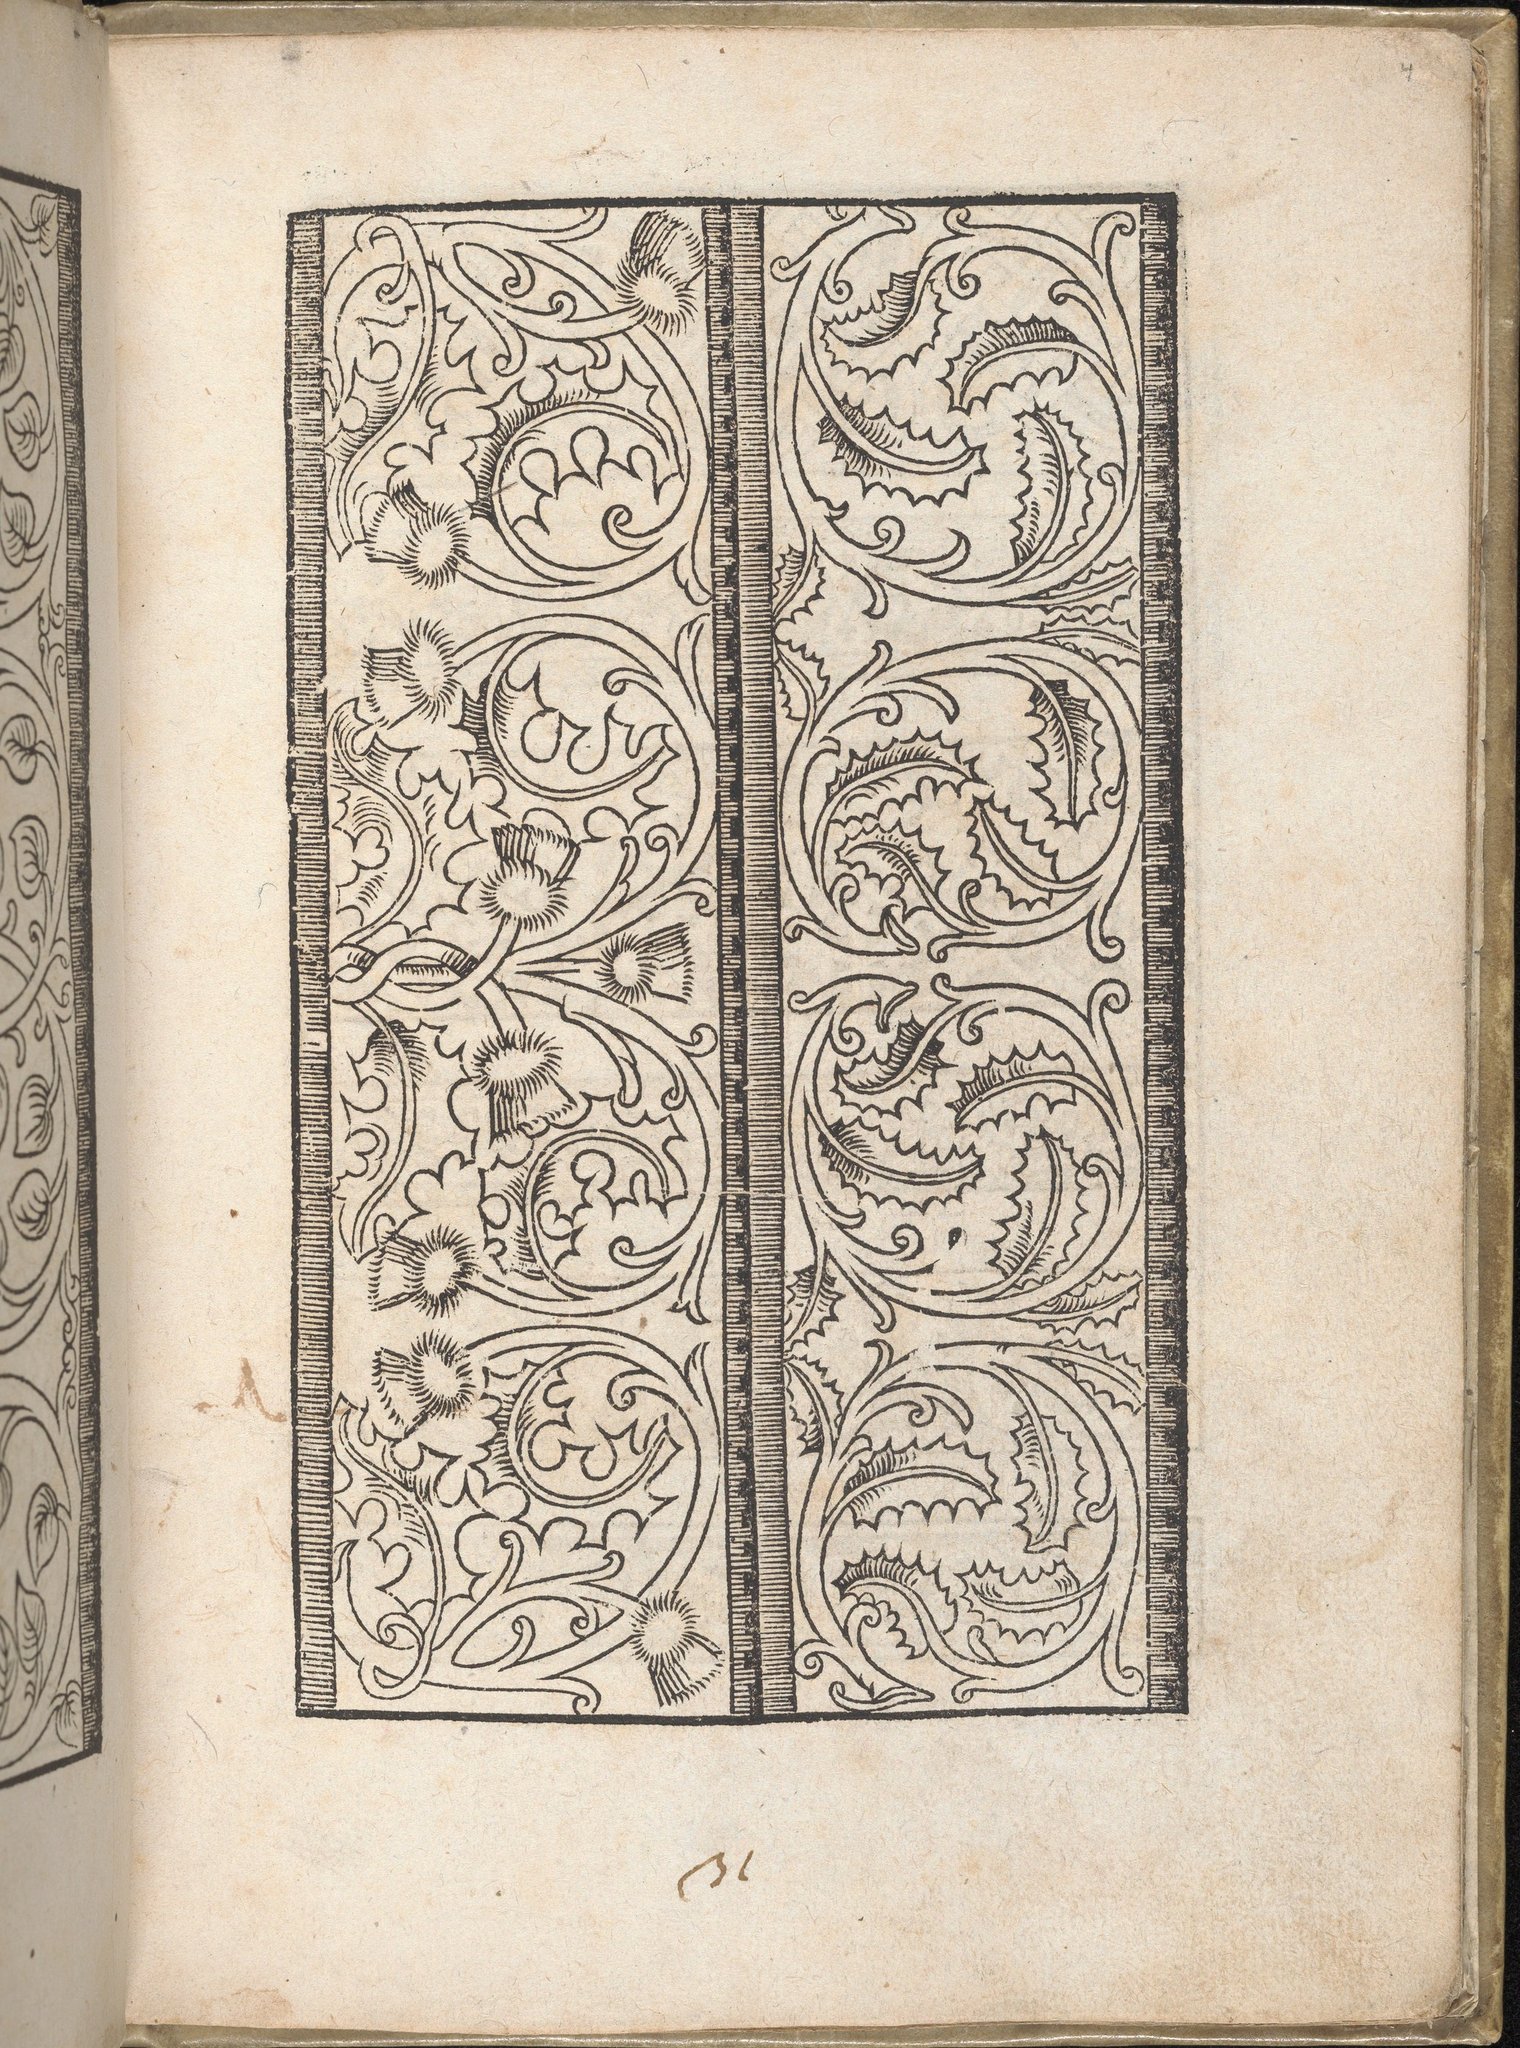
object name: book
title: Page 4v, from "Eyn New Kunstlichboich"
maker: peter quentel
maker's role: publisher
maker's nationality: german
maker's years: 1500-1550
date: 1529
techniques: woodcut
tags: ornament